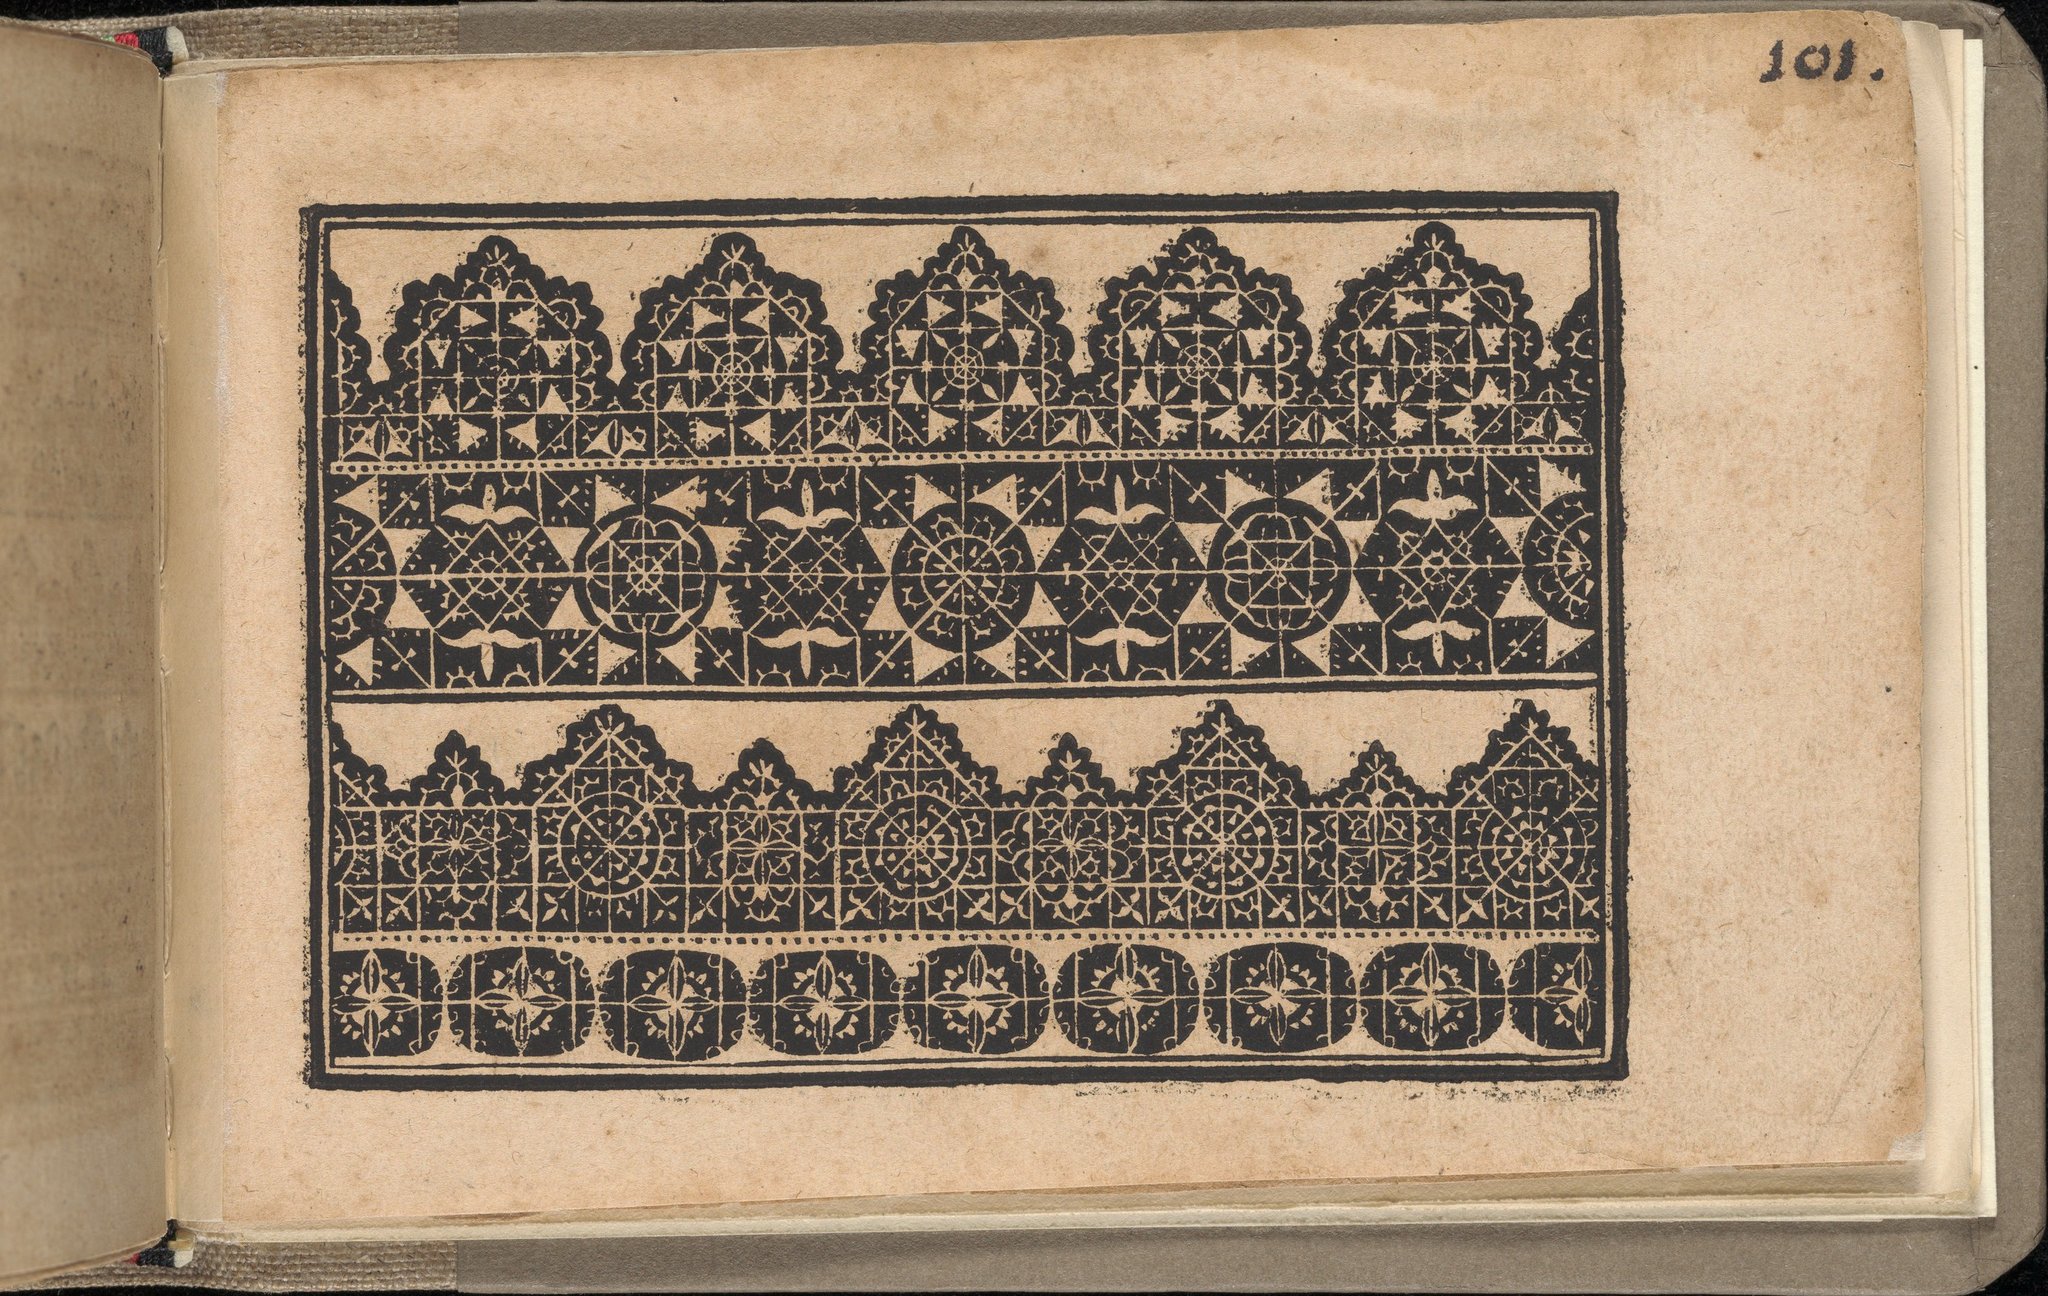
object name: book print ornament architecture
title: Schön newes Modelbuch (Page 101r)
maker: sigismundus latomus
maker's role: publisher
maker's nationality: german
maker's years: 1599-1632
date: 1608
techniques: woodcut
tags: ornament